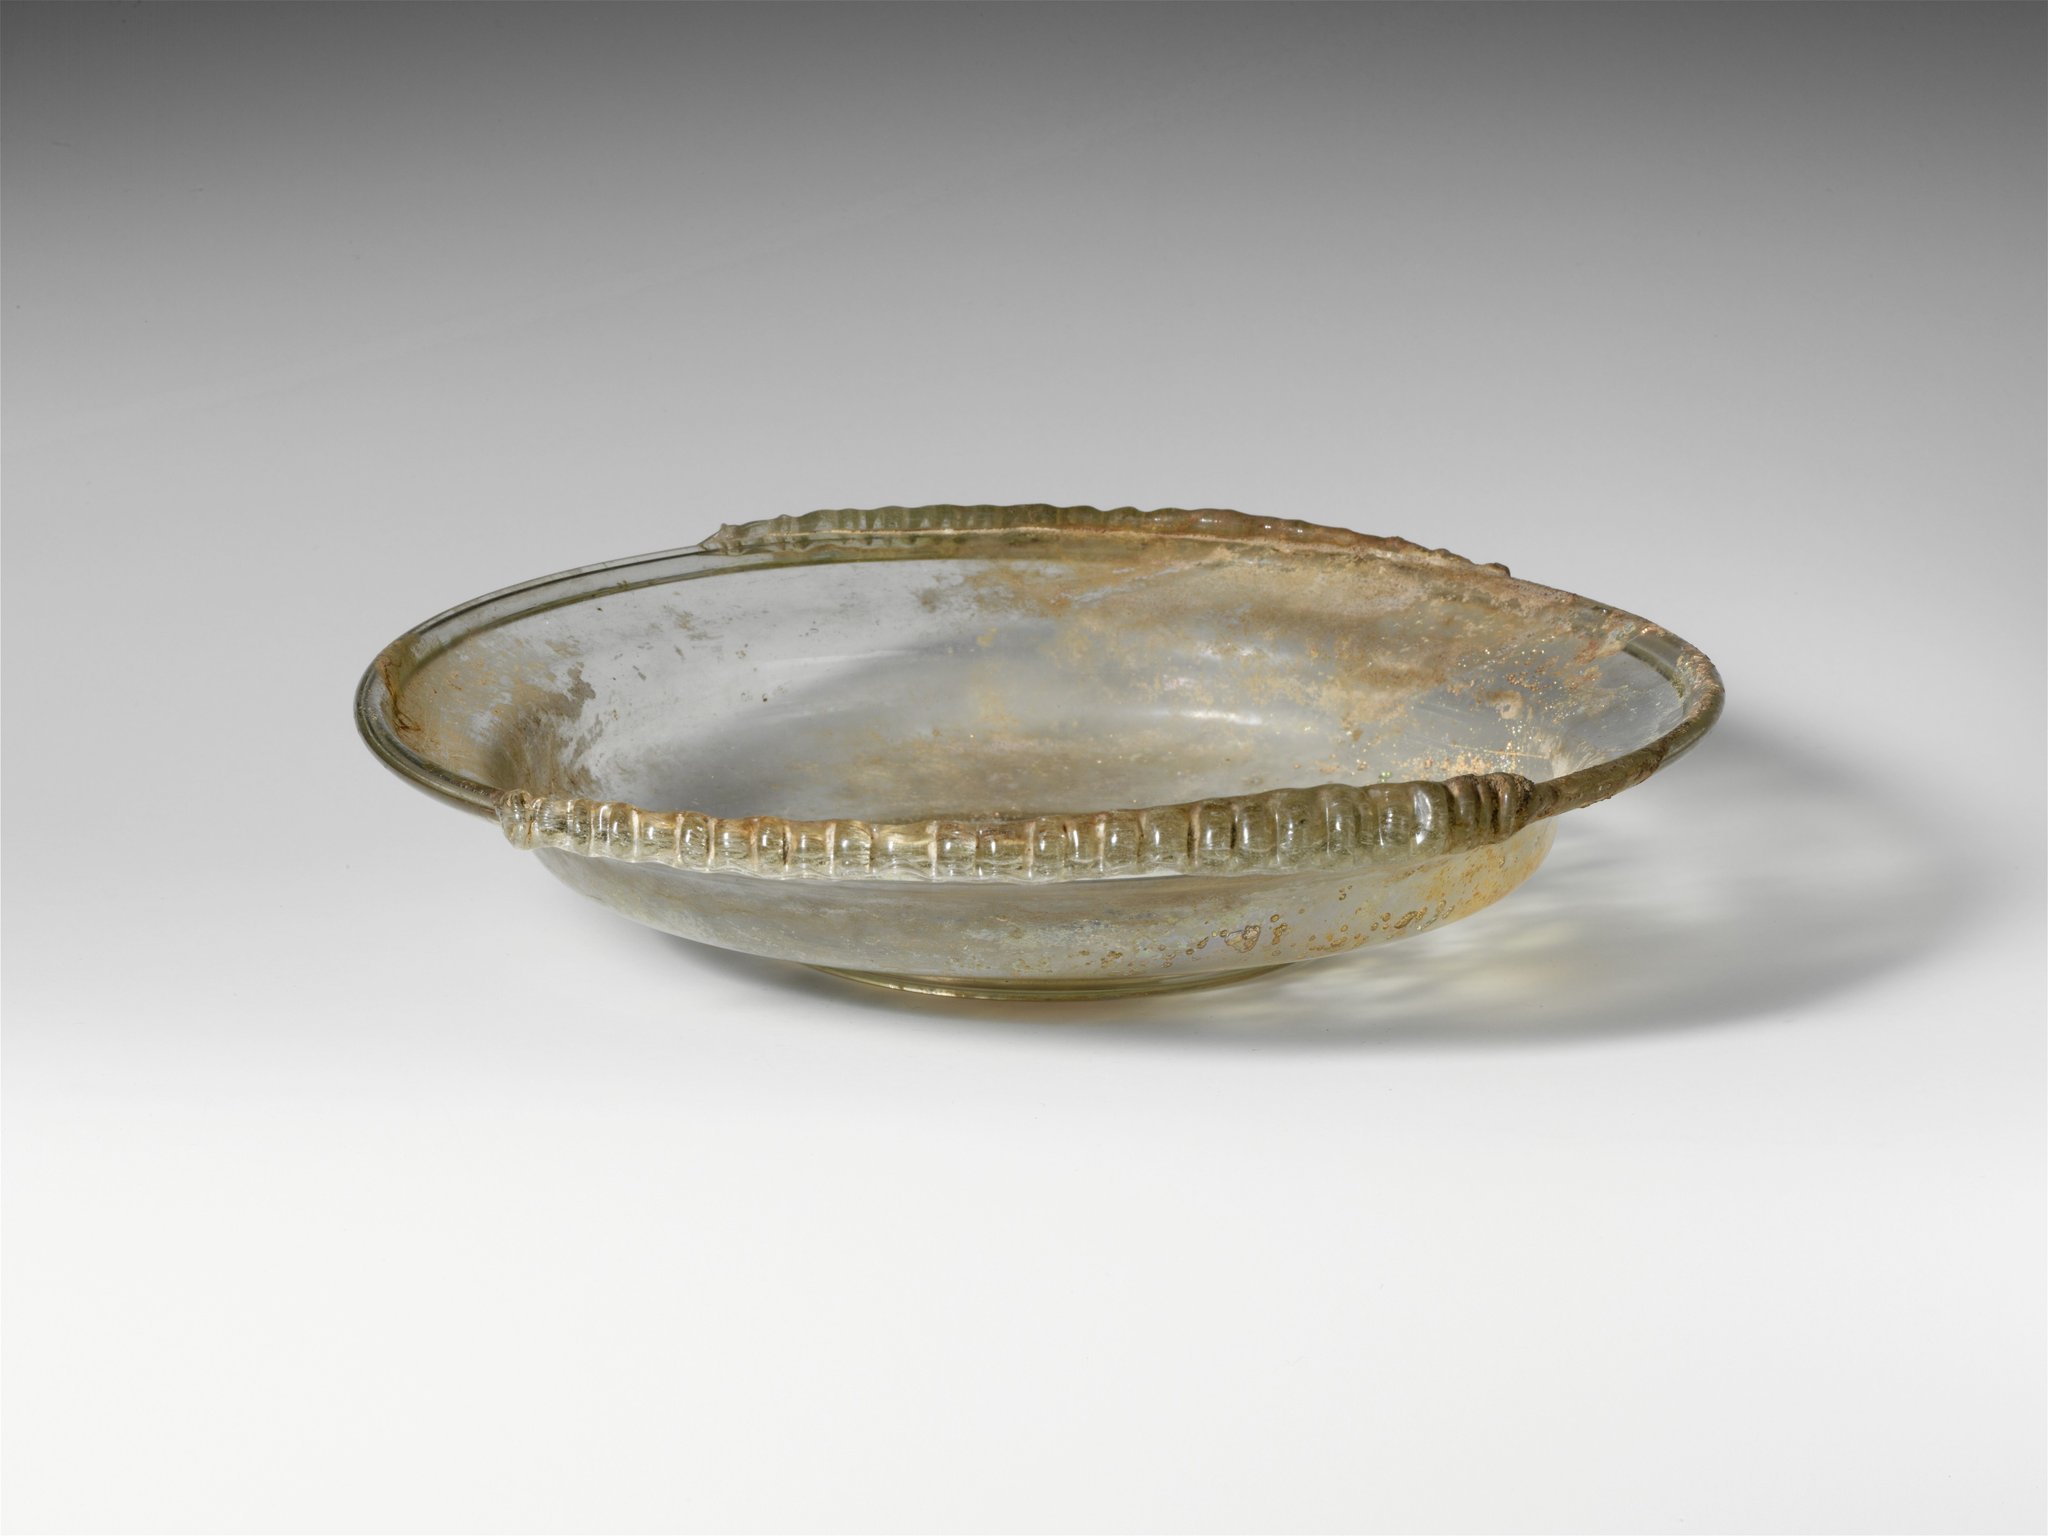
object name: dish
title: Glass dish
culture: roman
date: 67-233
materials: glass